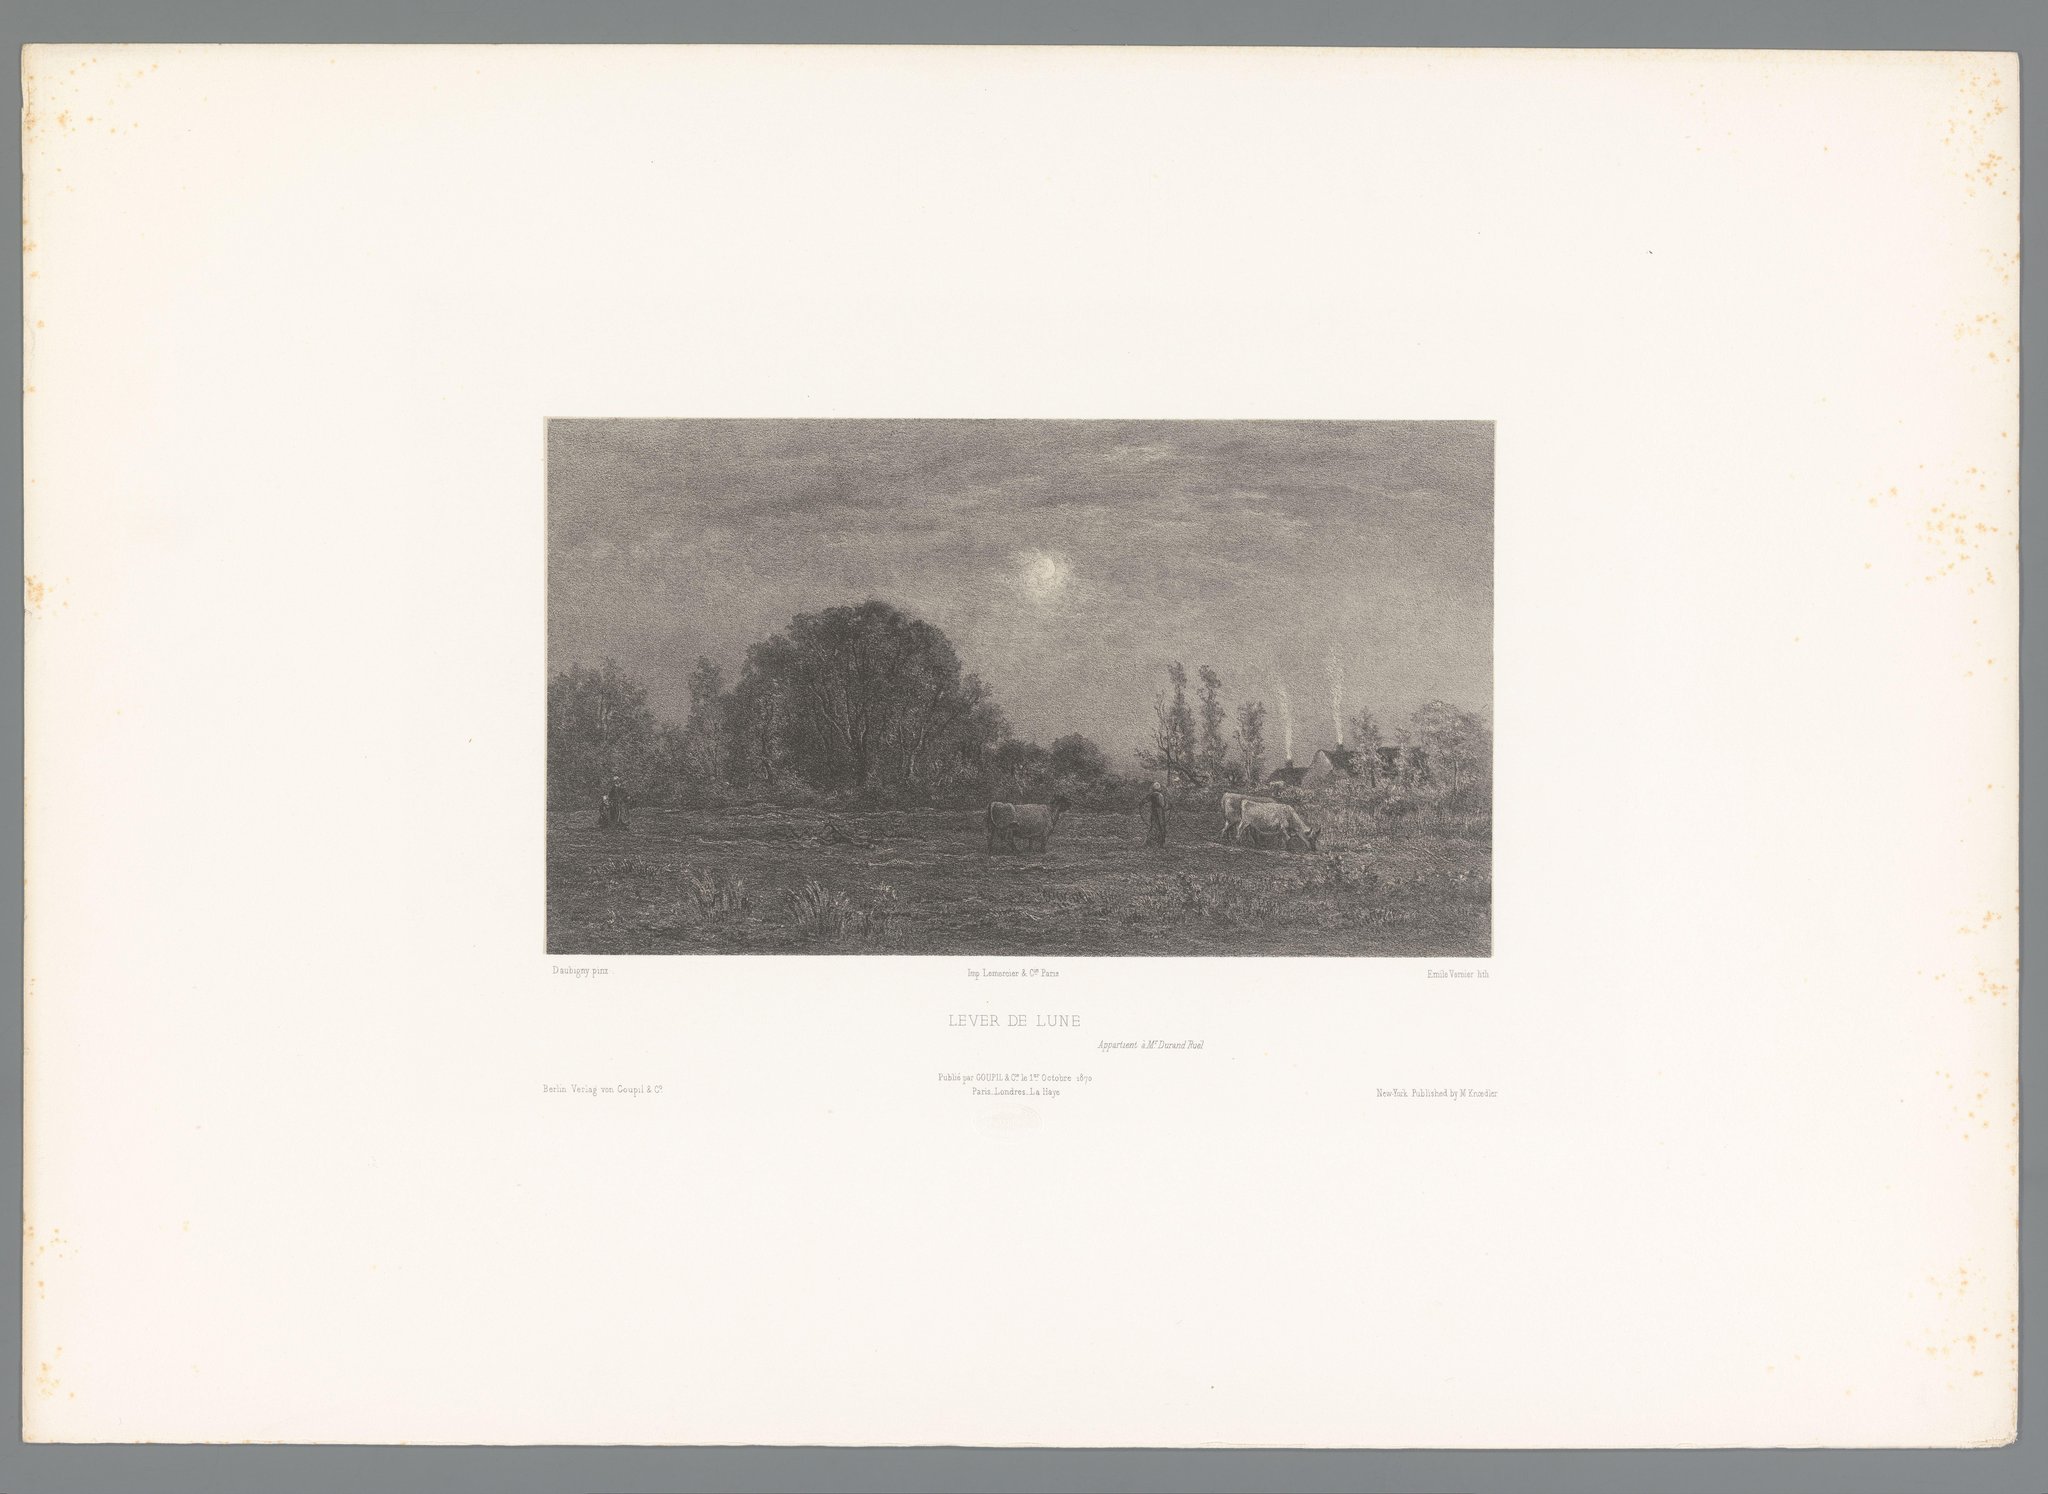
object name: print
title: Lever de lune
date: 1870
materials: paper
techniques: lithograph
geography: berlin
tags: waxing moon, i.e. facing this way: ), meadow, pasture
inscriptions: collector's mark: Lugt 1090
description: Het volgnummer in de serie is niet vermeld.